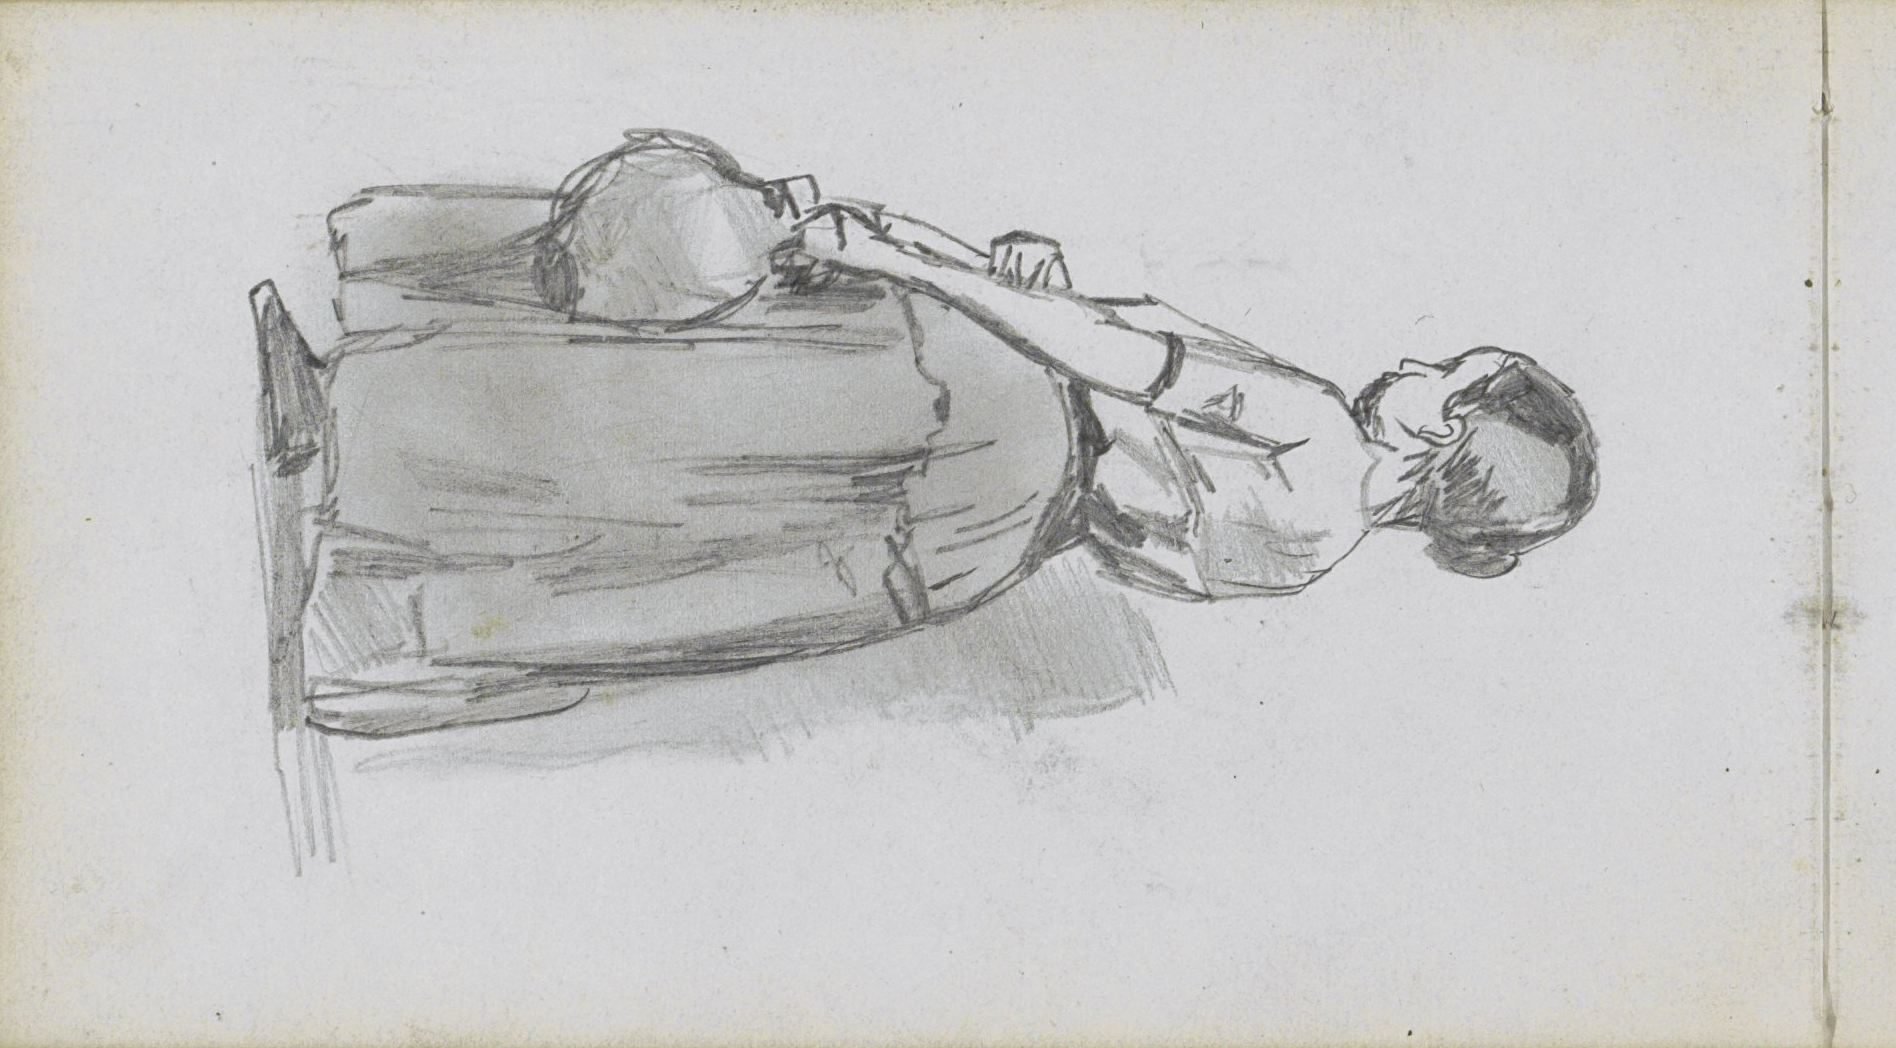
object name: sketchbook leaf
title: Staand meisje met een kruik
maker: johan hendrik weissenbruch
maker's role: draughtsman, painter, print maker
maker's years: 1824-1903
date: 1834-1903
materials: paper, pencil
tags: standing figure (+ young female (human being)), jar, jug (used as drinking-vessel)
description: Blad 13 verso uit een schetsboek met 39 bladen.